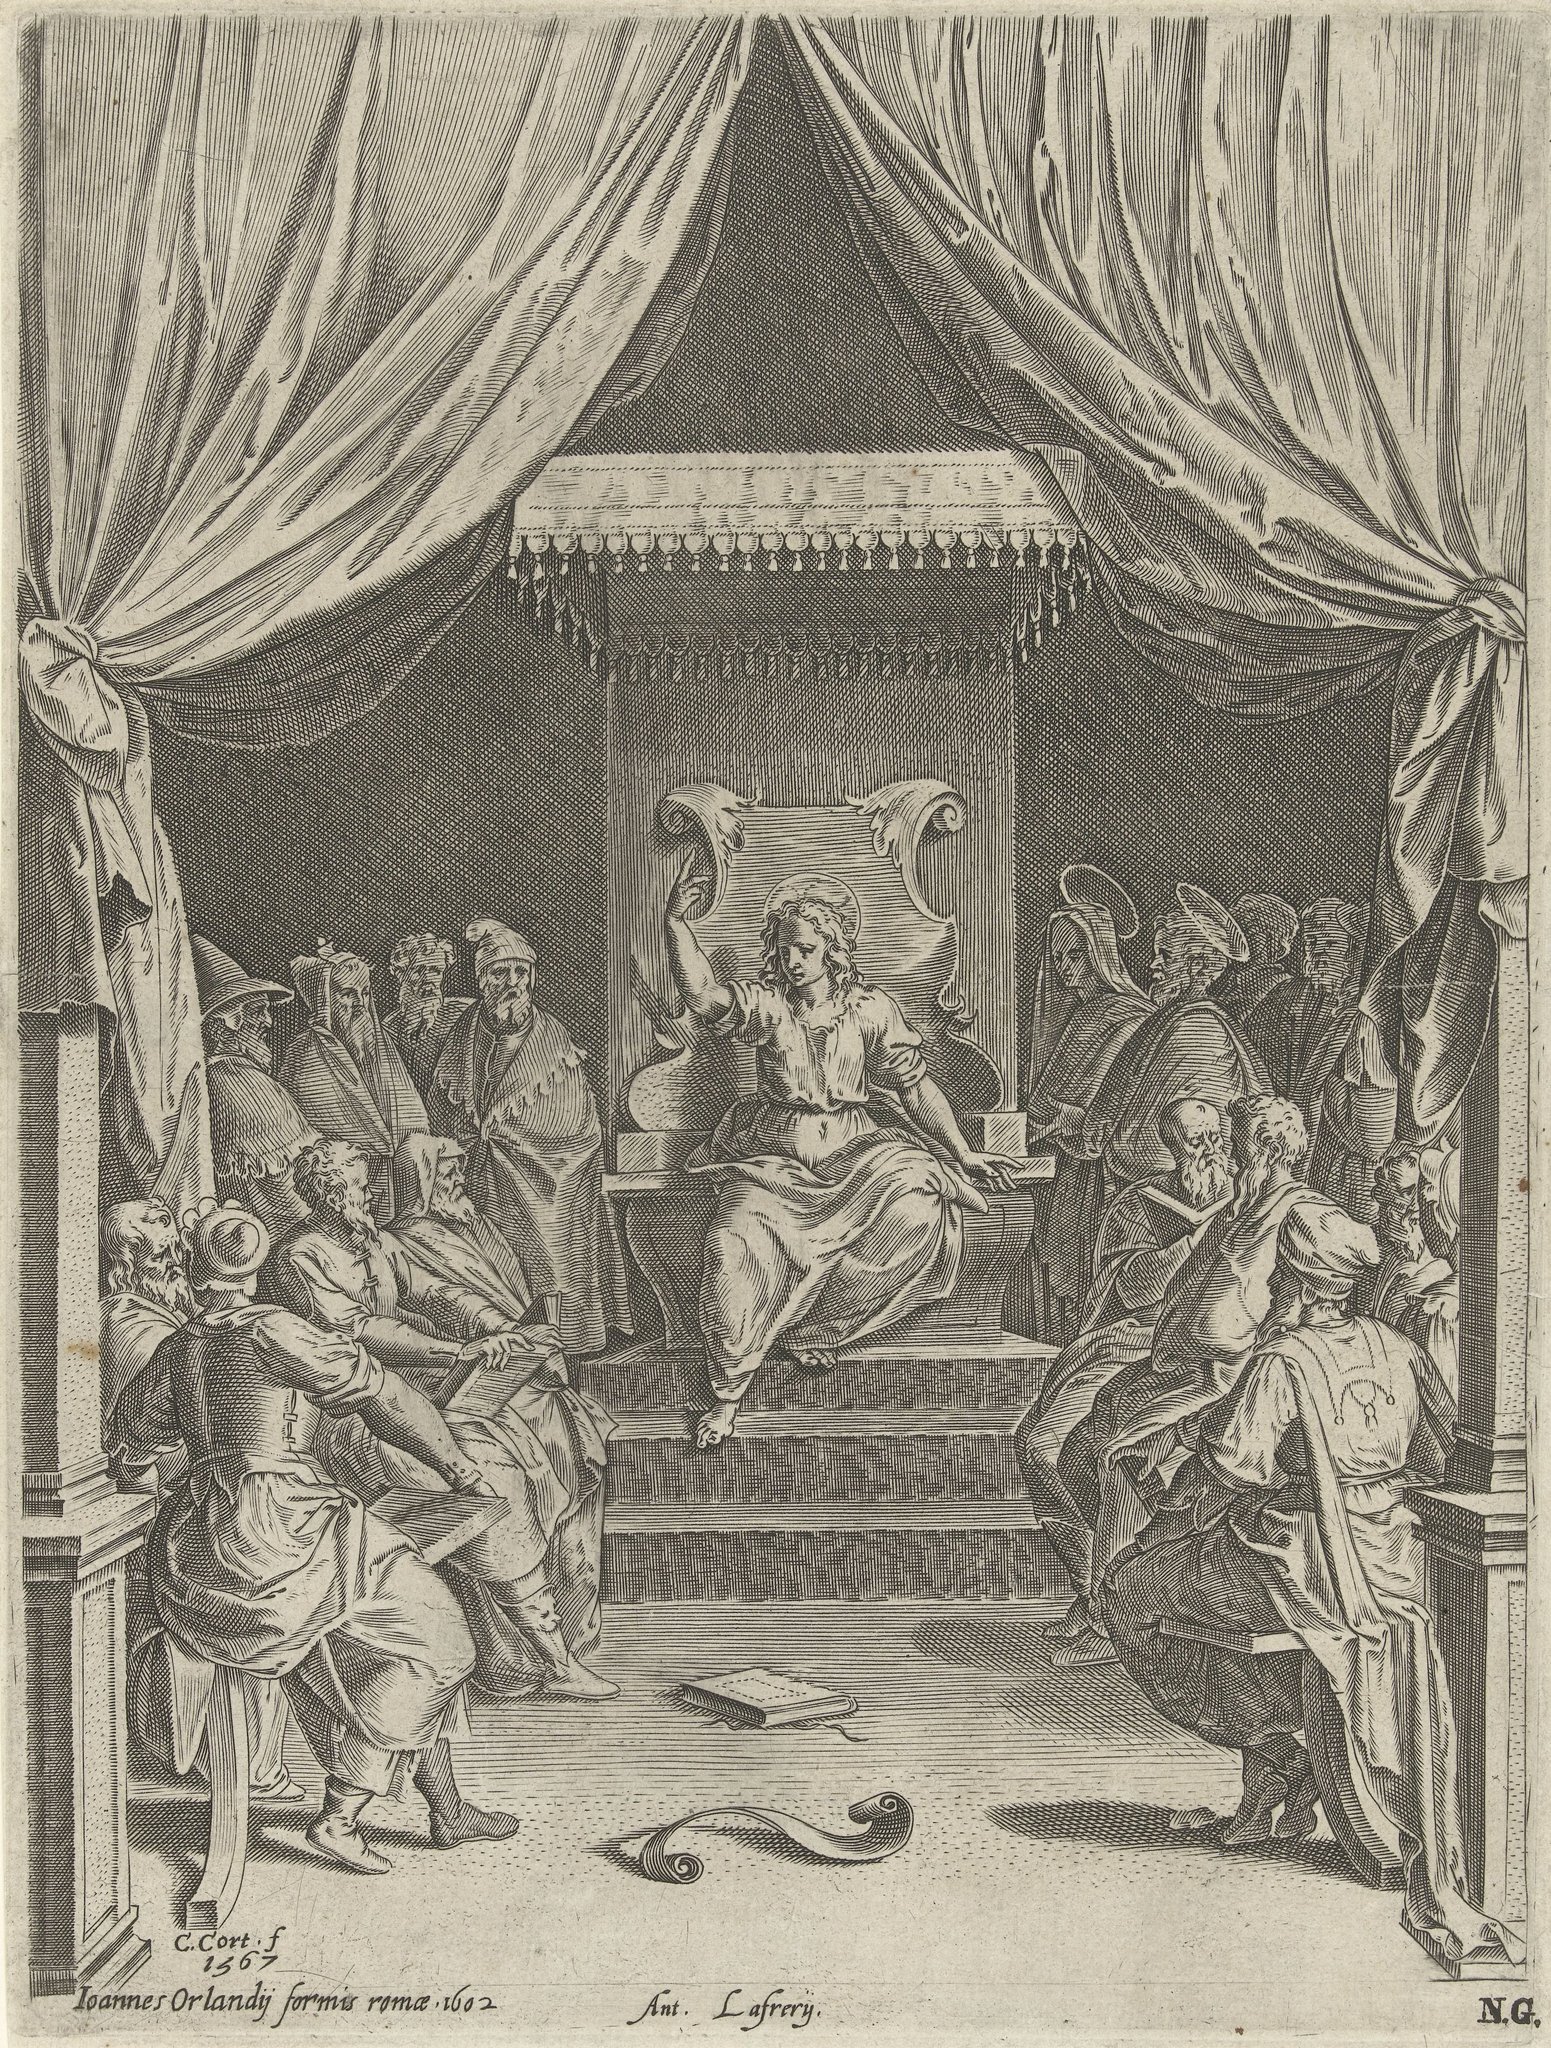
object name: print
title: Christus, op 12-jarige leeftijd, in discussie met de schriftgeleerden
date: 1602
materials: paper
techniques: engraving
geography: rome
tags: christ's dispute with the doctors in the temple; he counts his arguments on his fingers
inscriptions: address: ‘Ioannes Orlandy formis romae’, address: ‘Ant. Lafrerij.’, collector's mark: Lugt 2228, signature: ‘C. Cort. f.’, collector's mark: Lugt 1906, date: ‘1602’, date: ‘1567’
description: De 12-jarige Christus zit op een troon met baldakijn. Hij houdt een hand opgeheven in een spreekgebaar. Voor hem zitten de schriftgeleerden. In het midden ligt een boek op de grond. Naast de troon staan rechts Maria en Jozef.